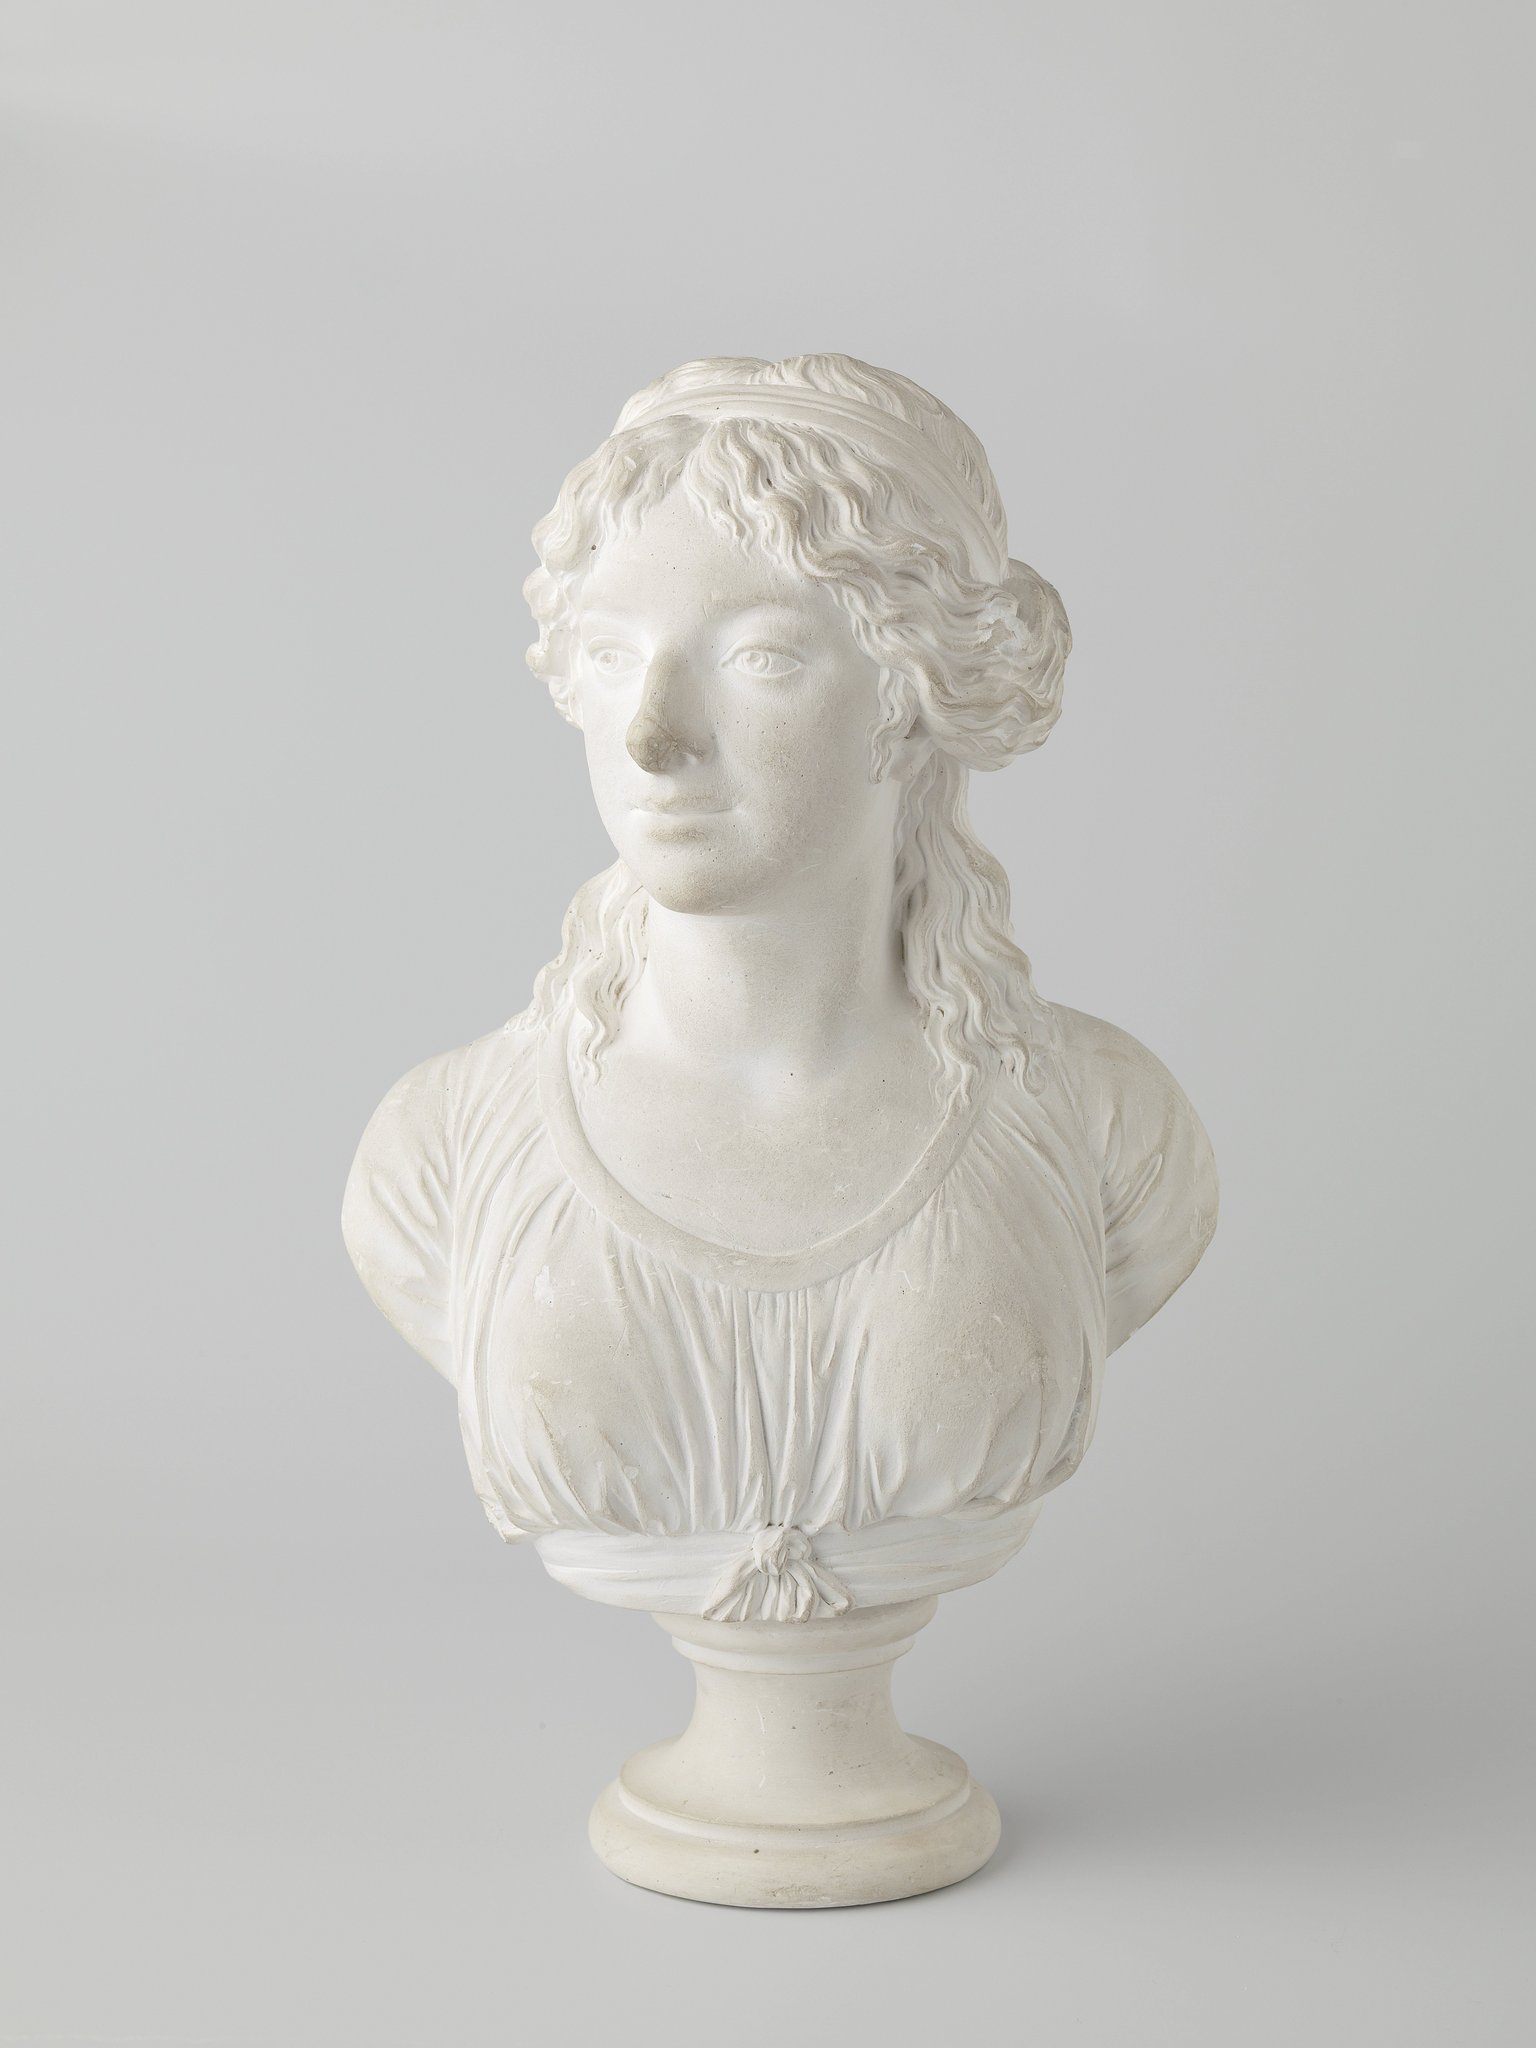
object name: sculpture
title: Borstbeeld van een jonge vrouw, mogelijk Auguste-Louise-Therese Roland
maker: philippe laurent roland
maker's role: sculptor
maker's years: 1746-1816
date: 1798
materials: gypsum